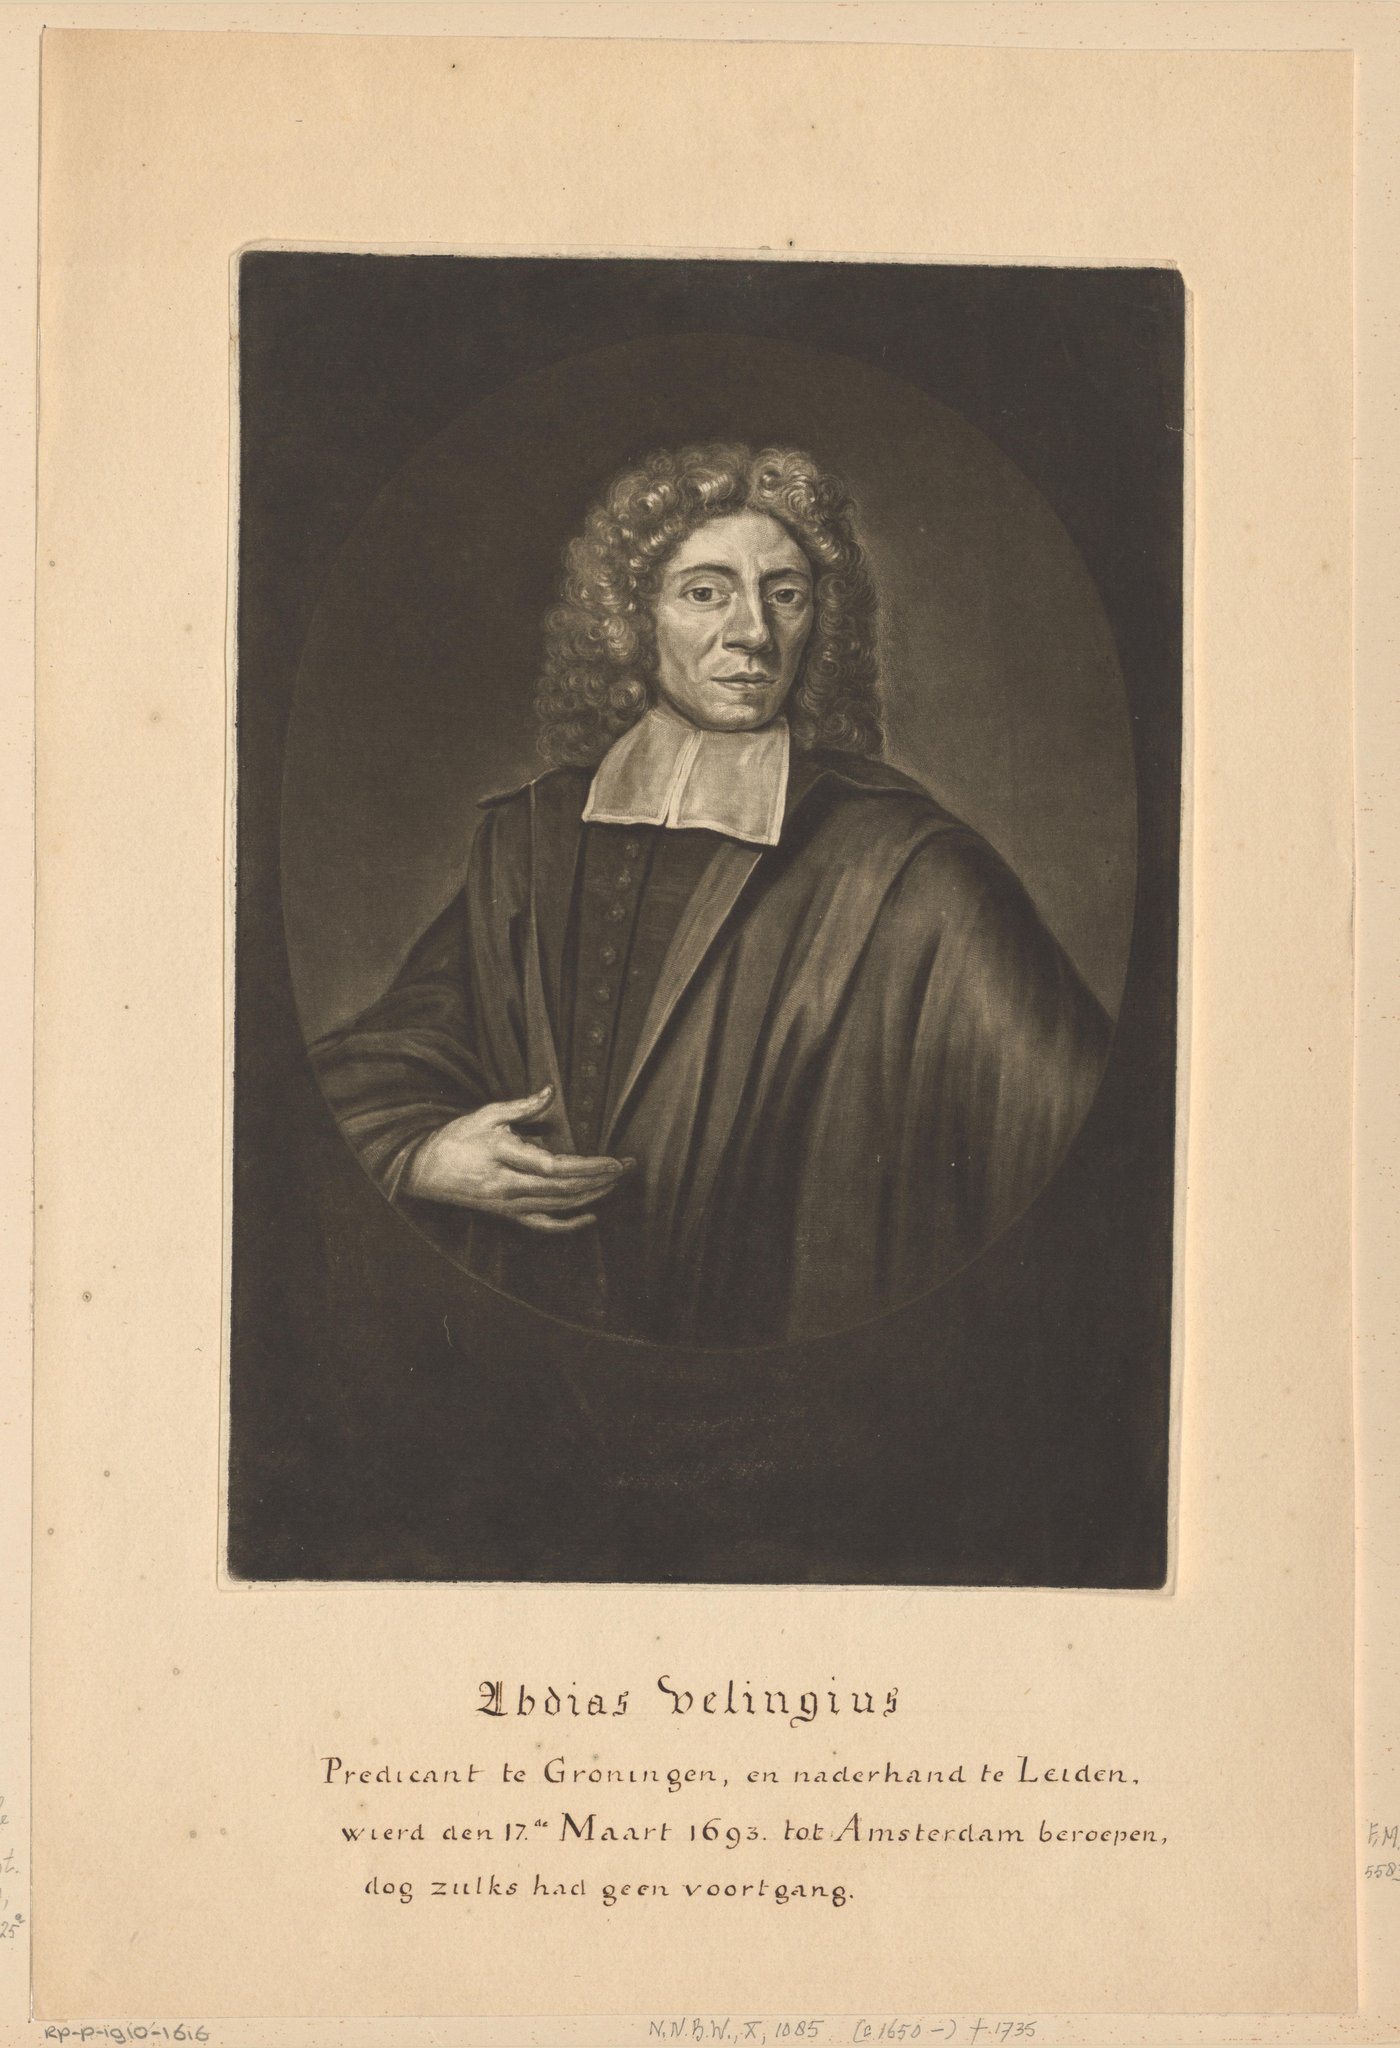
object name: print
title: Portret van Abdias Velingius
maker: jacob gole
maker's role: print maker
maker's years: 1660-1724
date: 1680-1724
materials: paper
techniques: mezzotint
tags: leiden, functionaries and dignitaries (with name) ~ protestant churches, historical persons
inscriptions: collector's mark: Lugt 2228